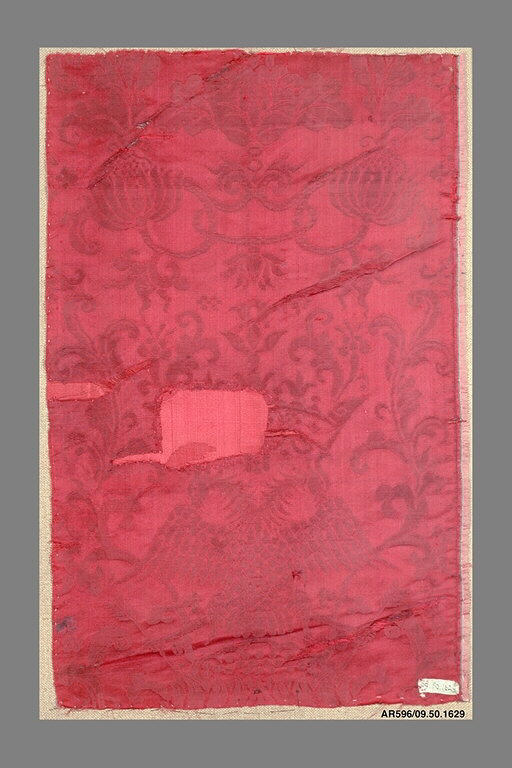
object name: piece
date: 1551-1600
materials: silk